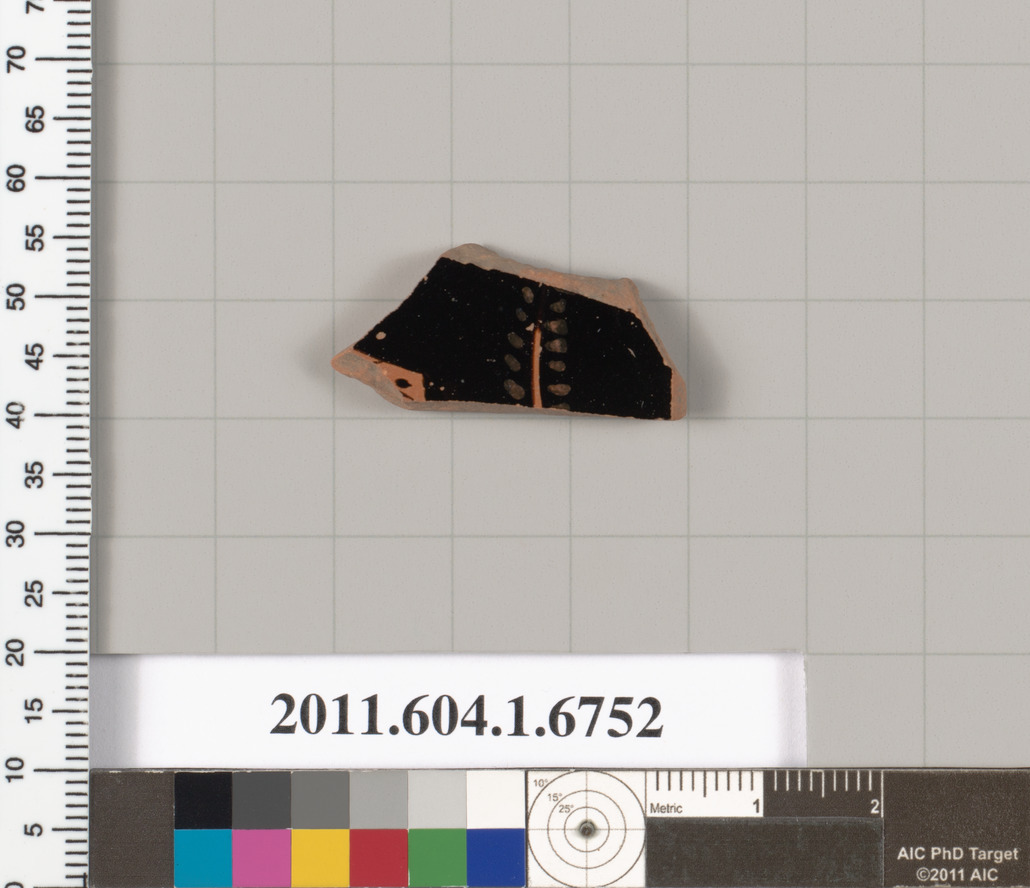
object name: kylix fragment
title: Terracotta fragment of a kylix (drinking cup)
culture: greek, attic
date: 490-470 BCE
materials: terracotta